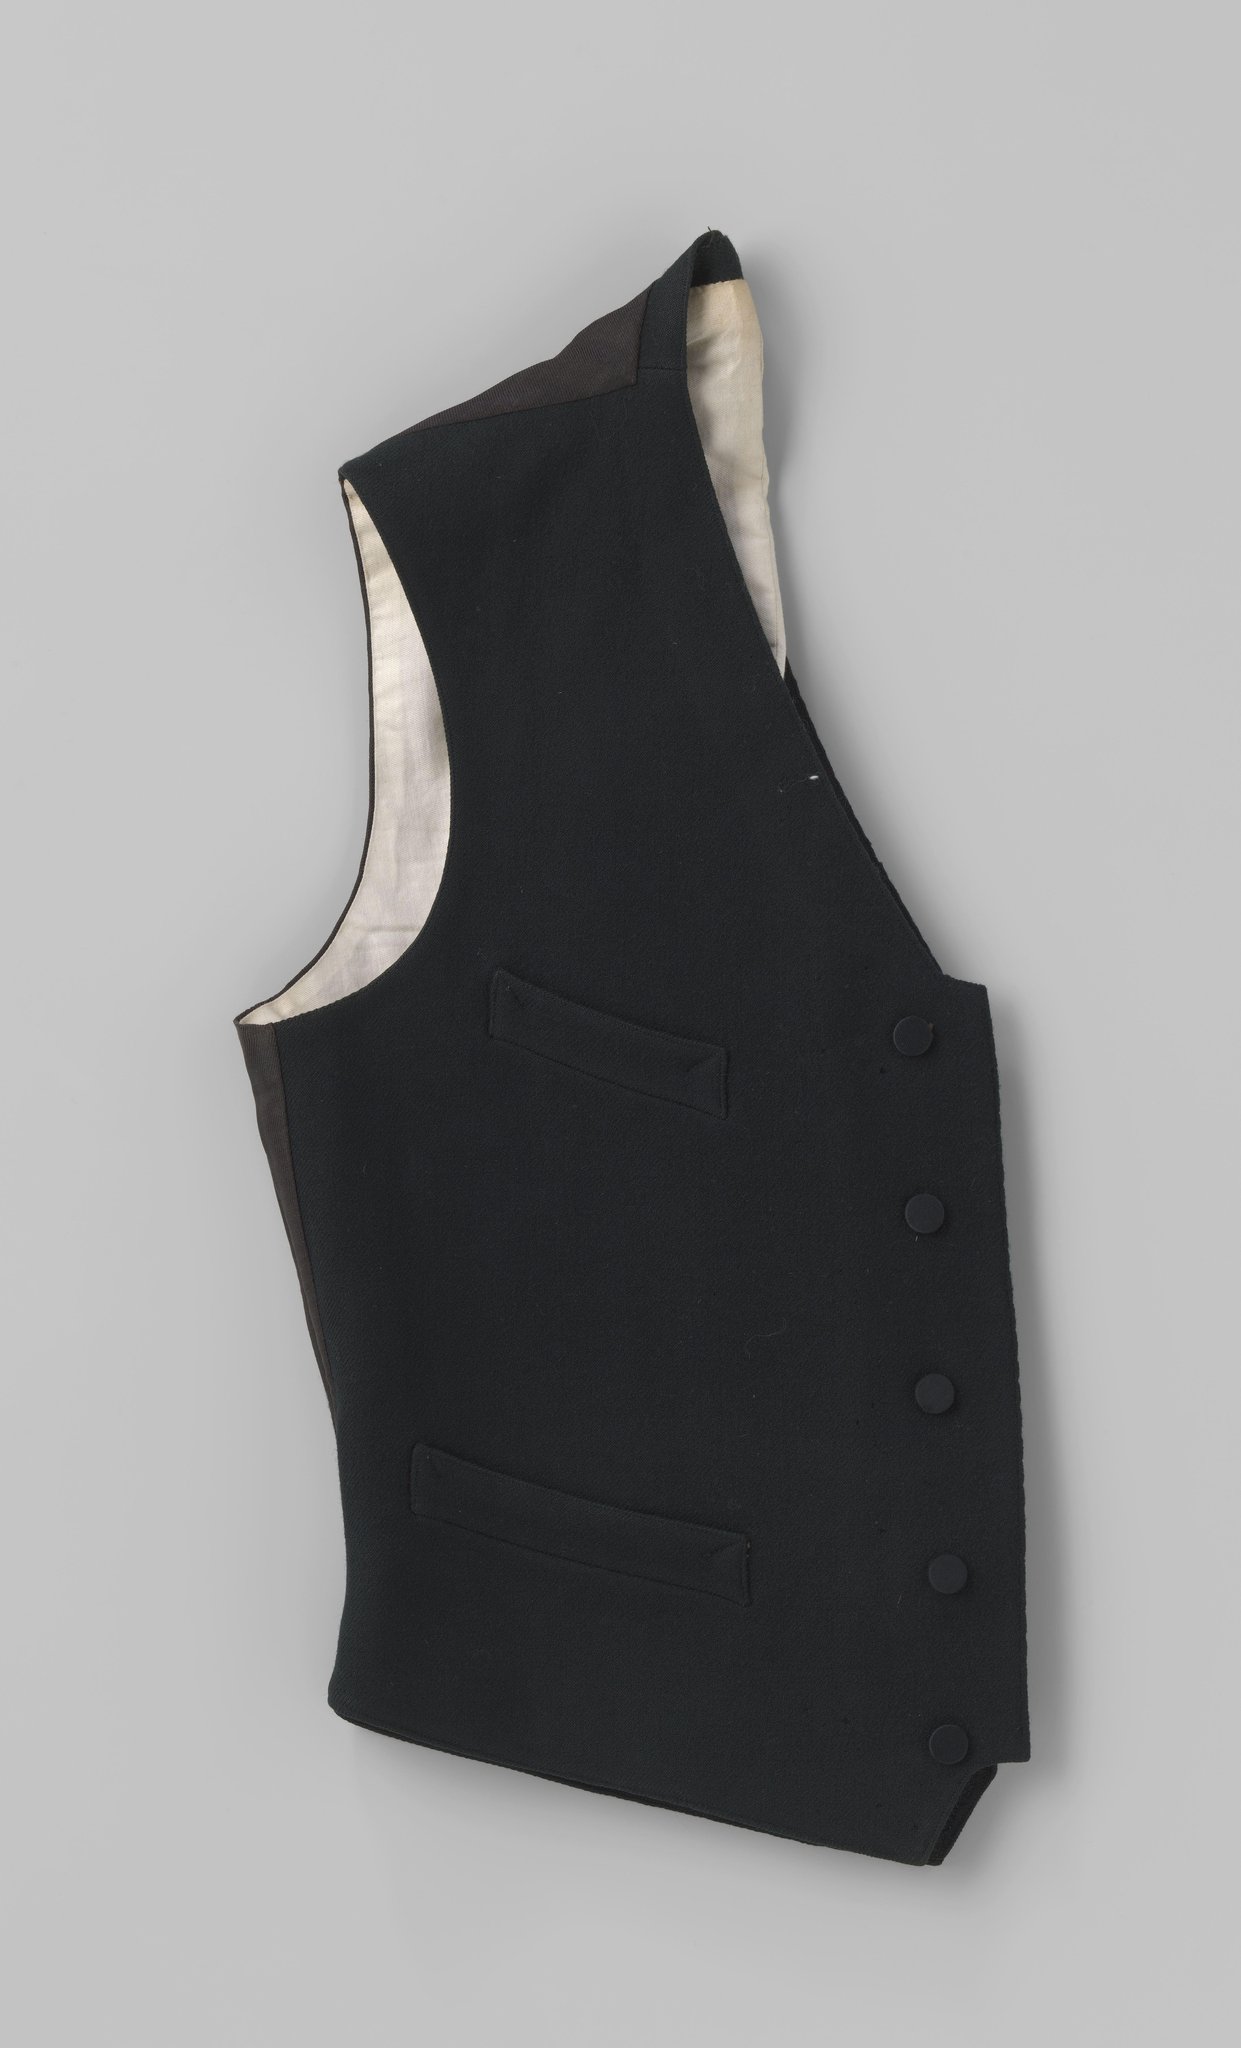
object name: main garment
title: Herenvest van zwarte en donkerblauwe, ruige keperstof van wol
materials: silk, wool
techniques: weave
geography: the hague